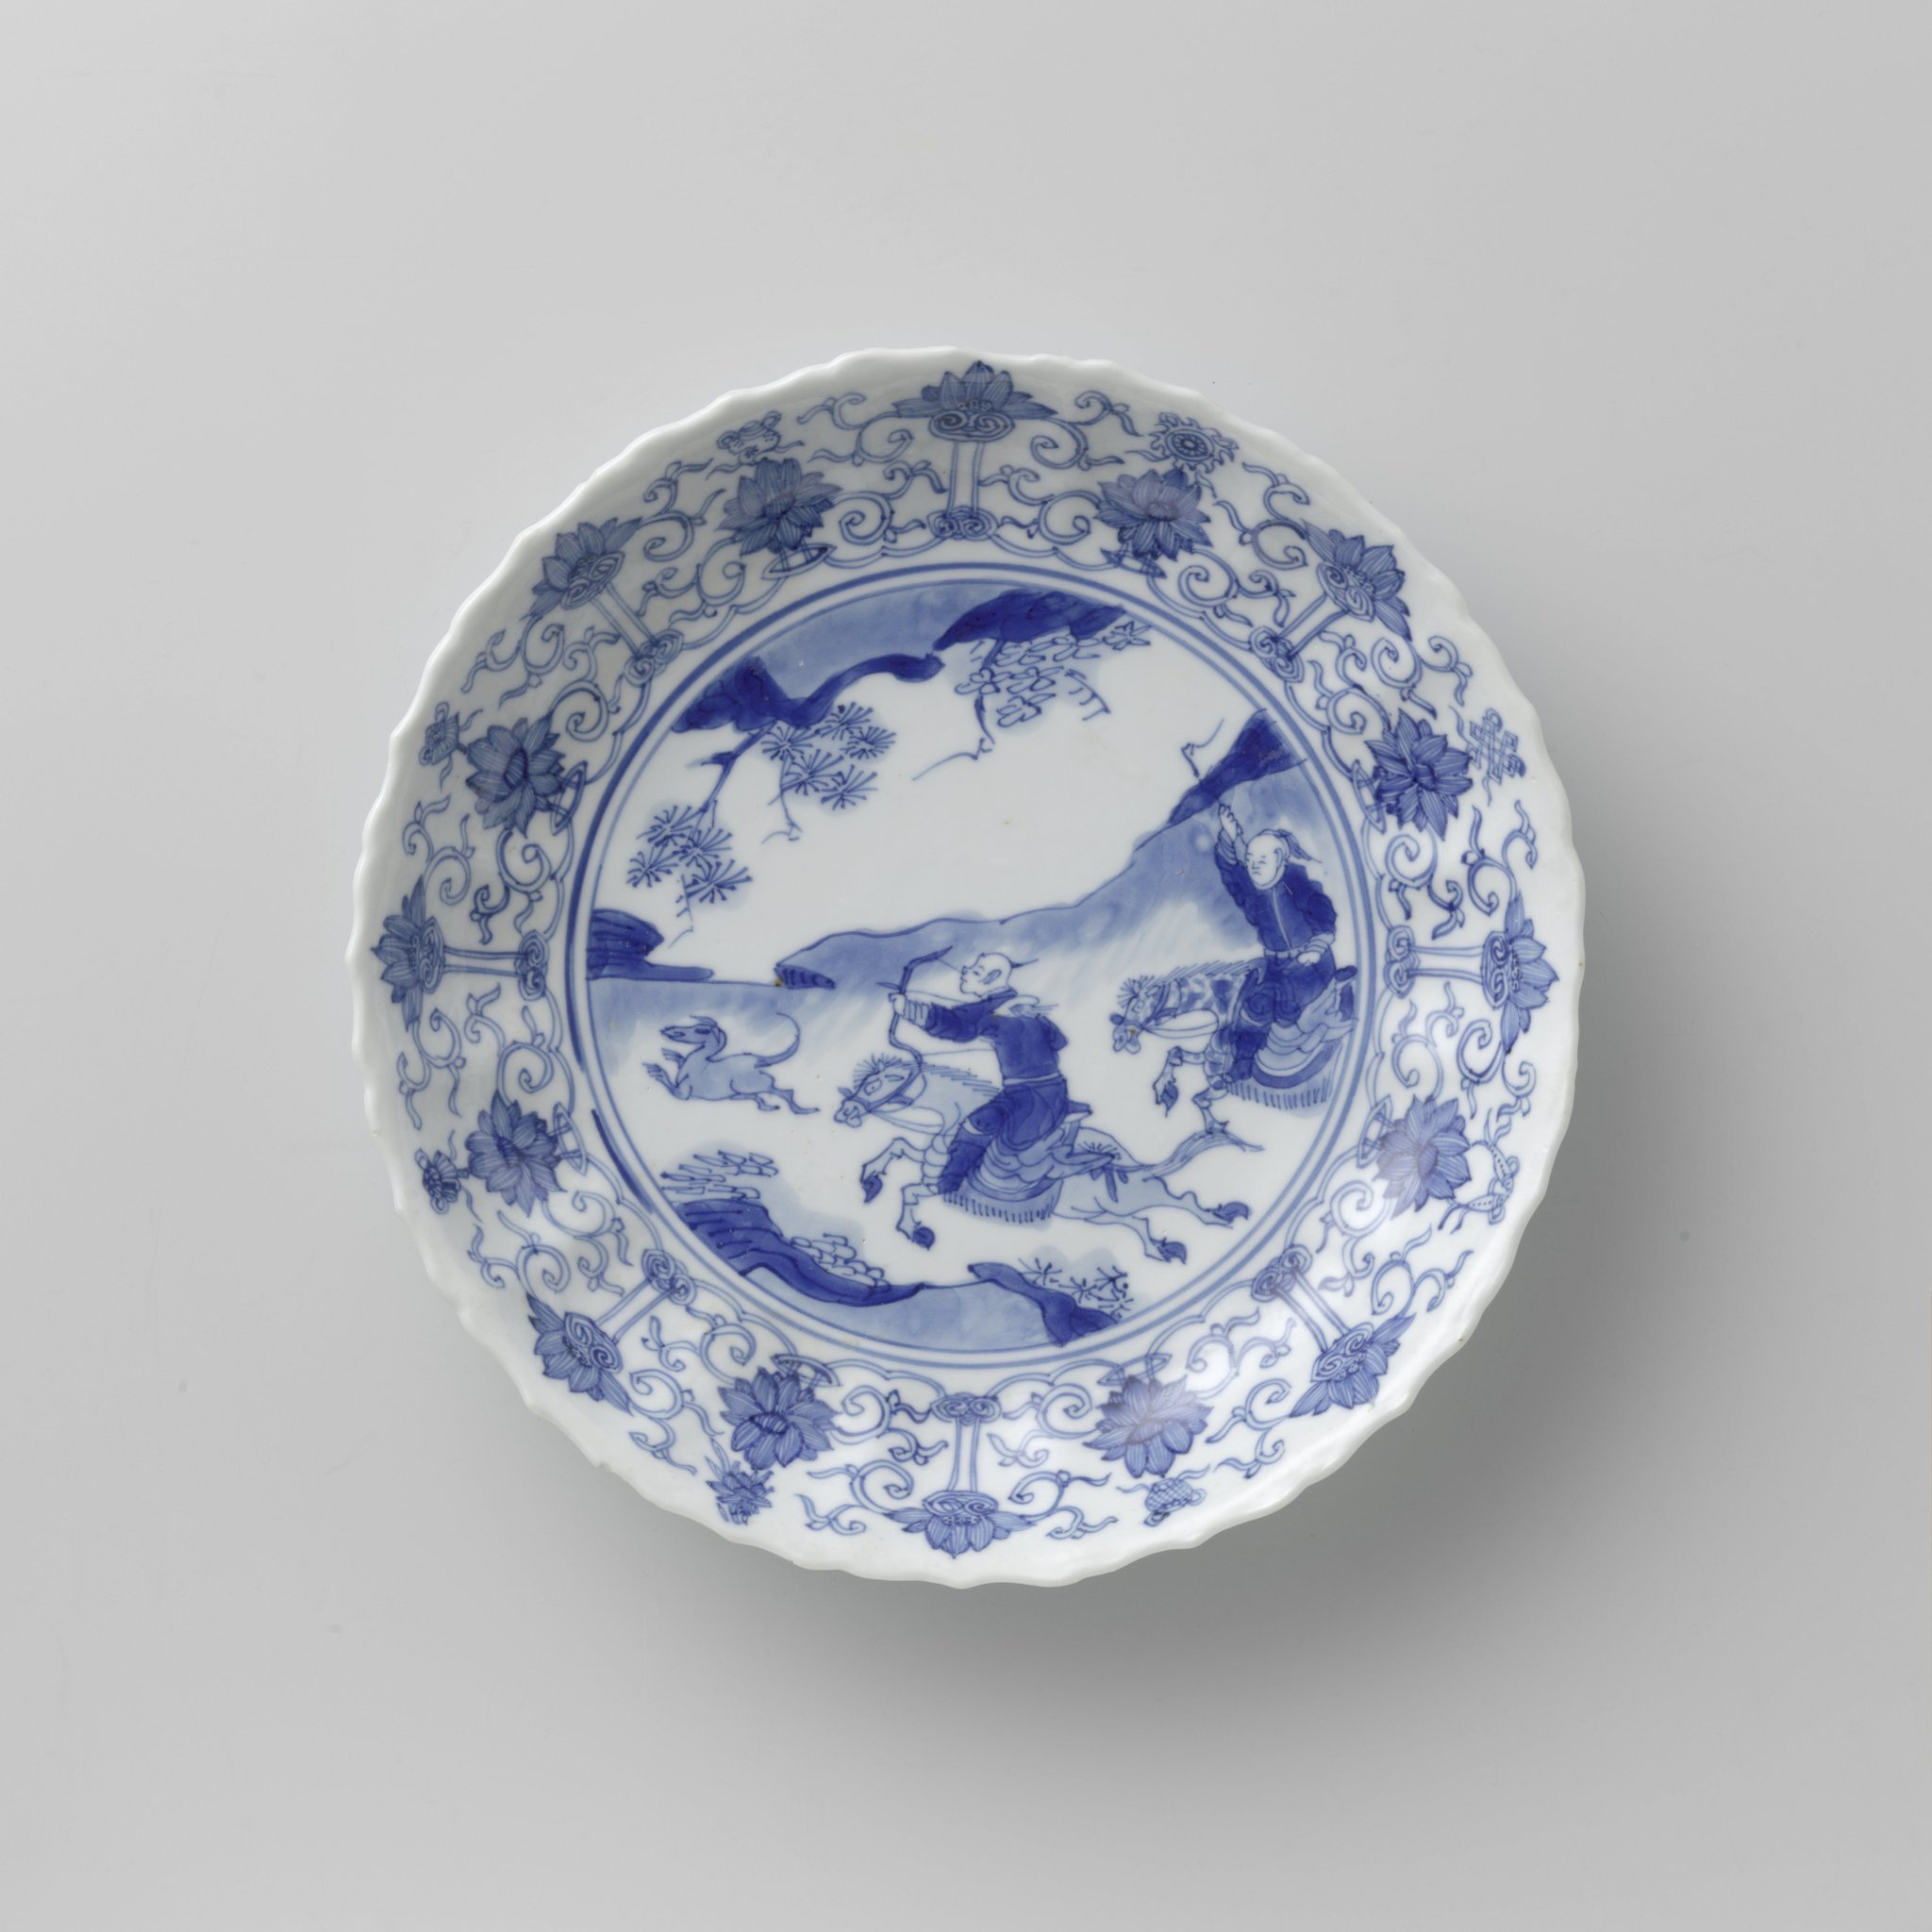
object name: dish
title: Saucer-dish with hunting scene, lotus scrolls and auspicious symbols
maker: Anonymous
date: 1700-1724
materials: cobalt, glaze, paint, porcelain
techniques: firing, forming, turning, vitrification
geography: china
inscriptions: mark